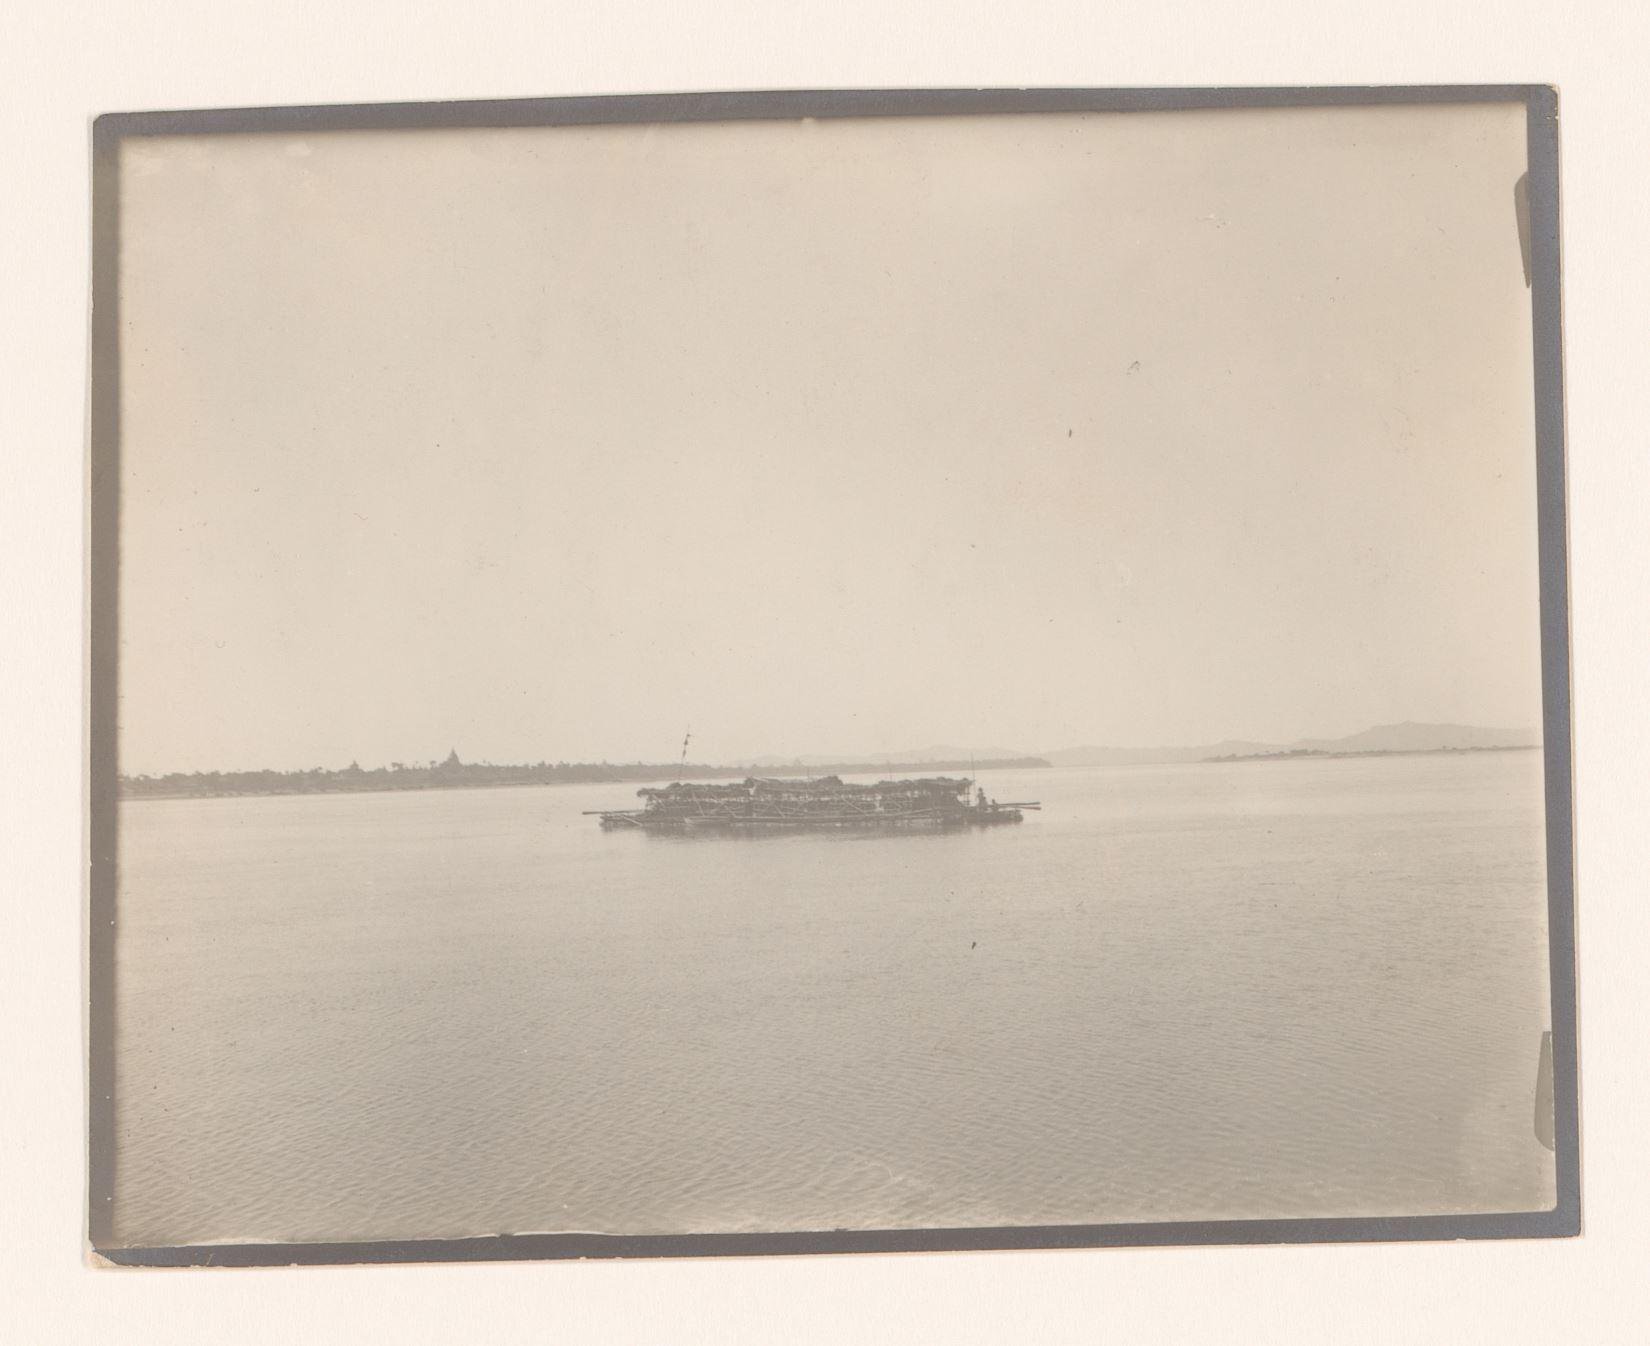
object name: photograph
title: Een houten vlot in het water met bergen in de verte, Zuid-Oost Azië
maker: jan adriani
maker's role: fotograaf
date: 1907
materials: photographic support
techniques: gelatin silver print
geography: southeast asia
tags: raft